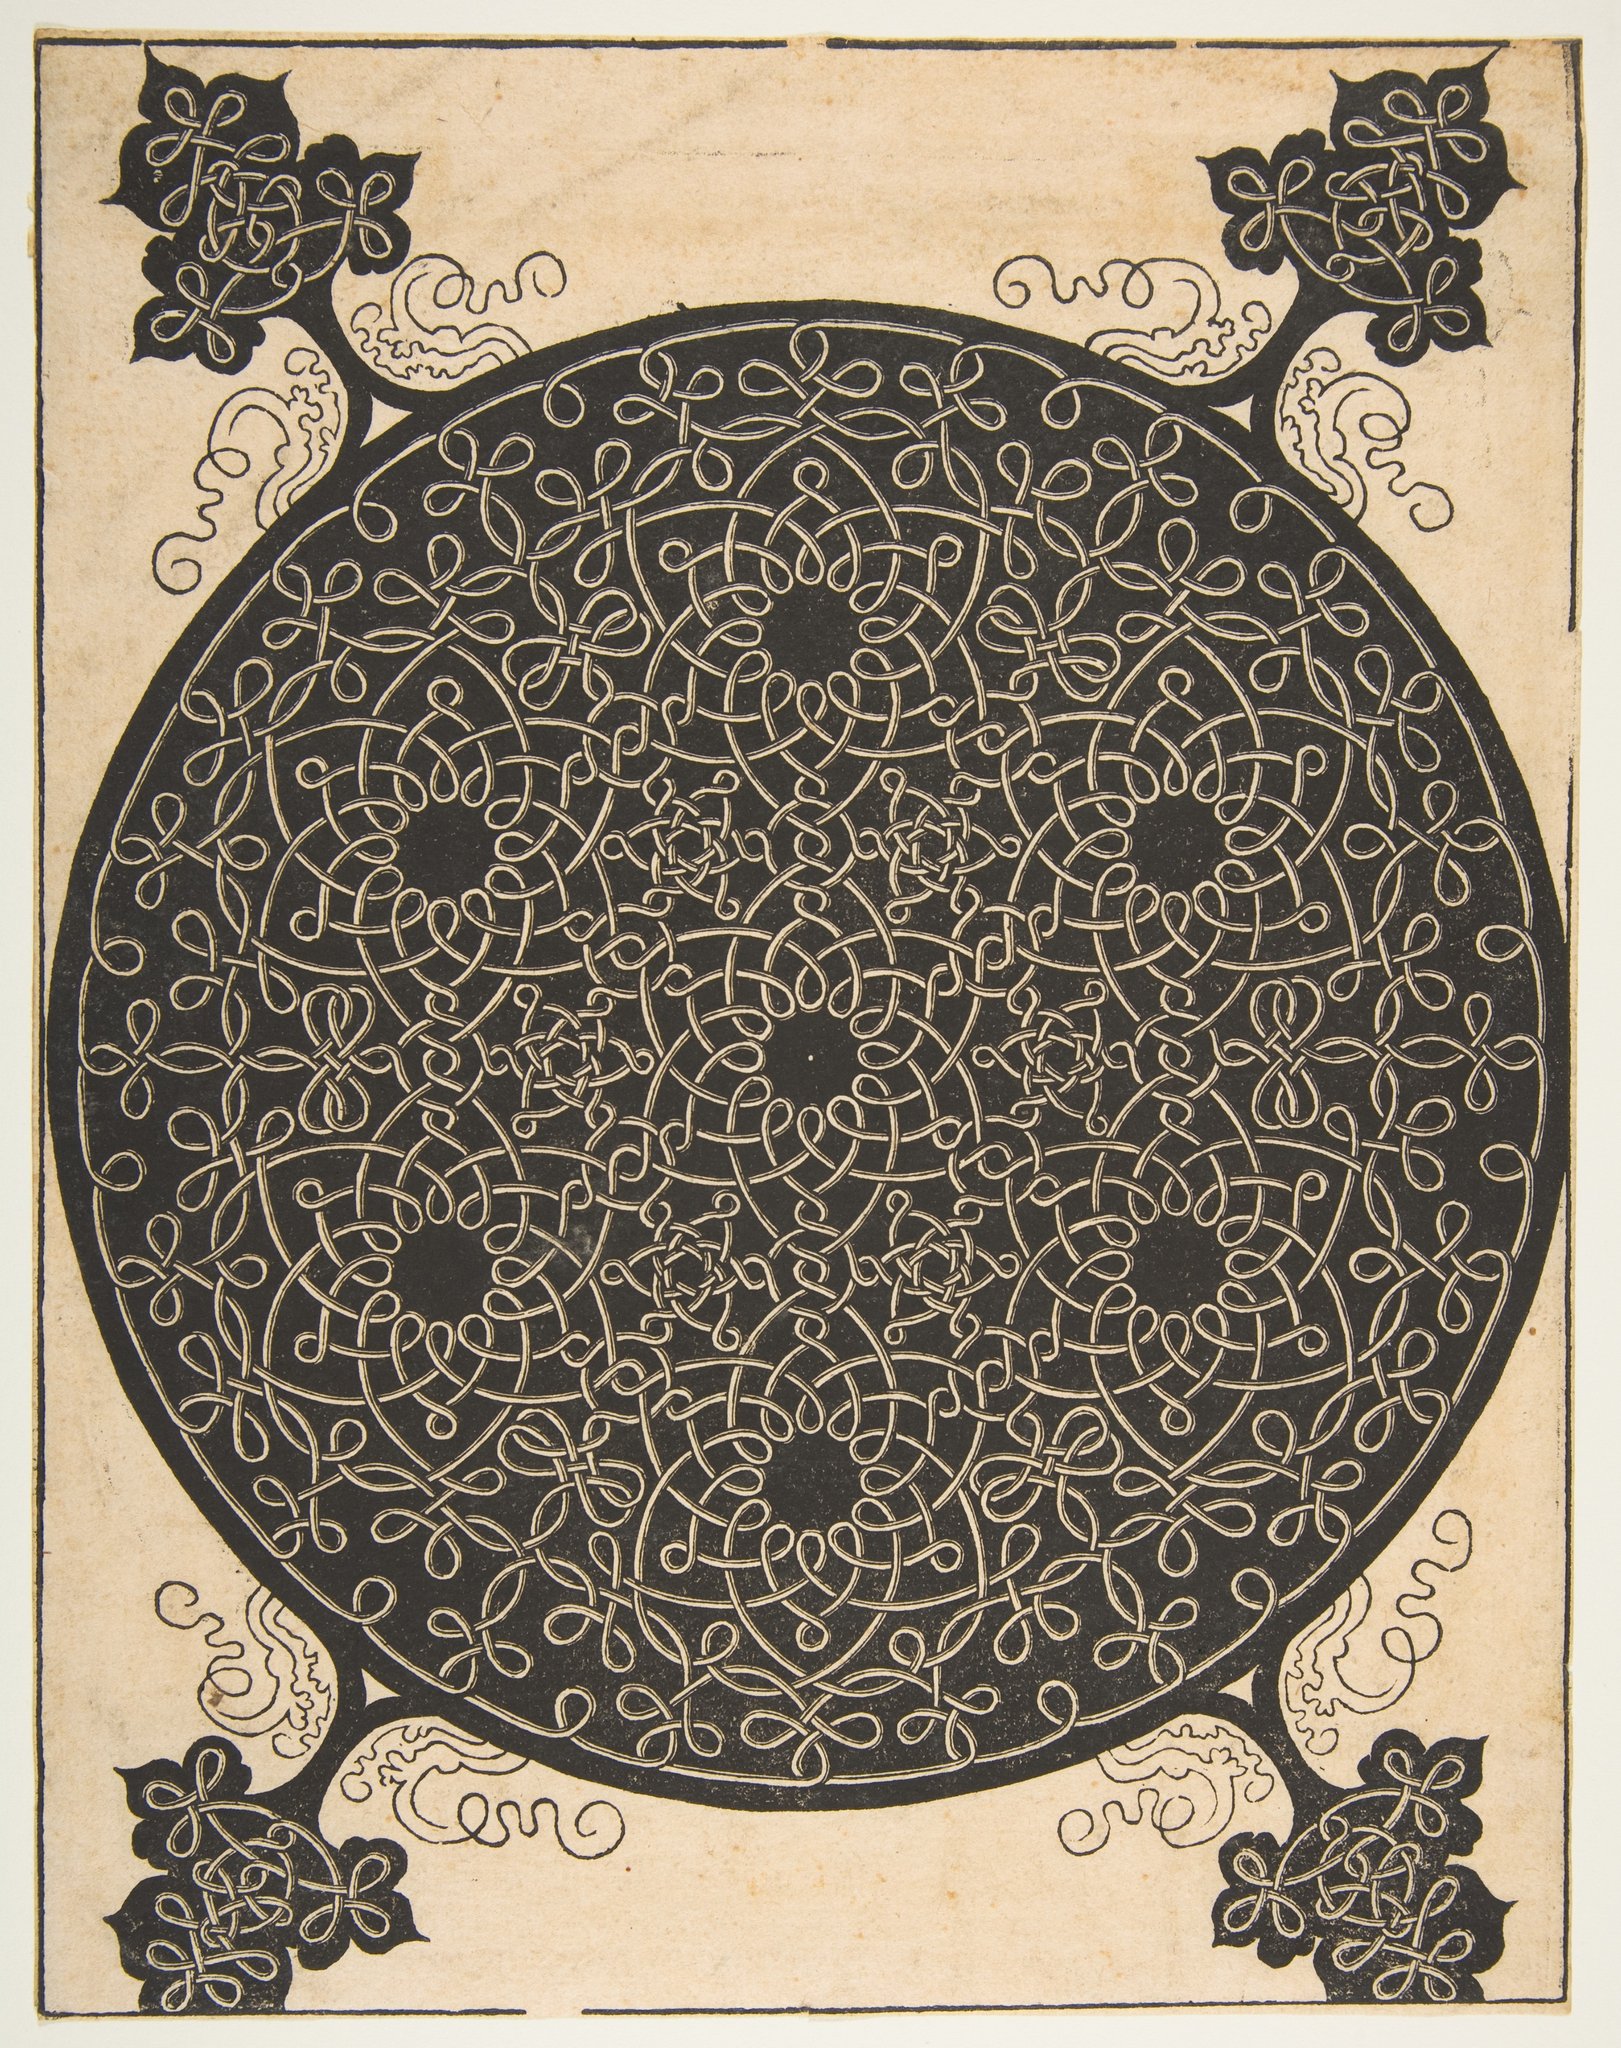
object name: collection ornament architecture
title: Embroidery Pattern with Seven Six-pointed Stars and Four Corner Pieces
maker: albrecht dürer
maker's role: artist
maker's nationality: german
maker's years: 1471-1528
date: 1521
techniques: woodcut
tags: ornament